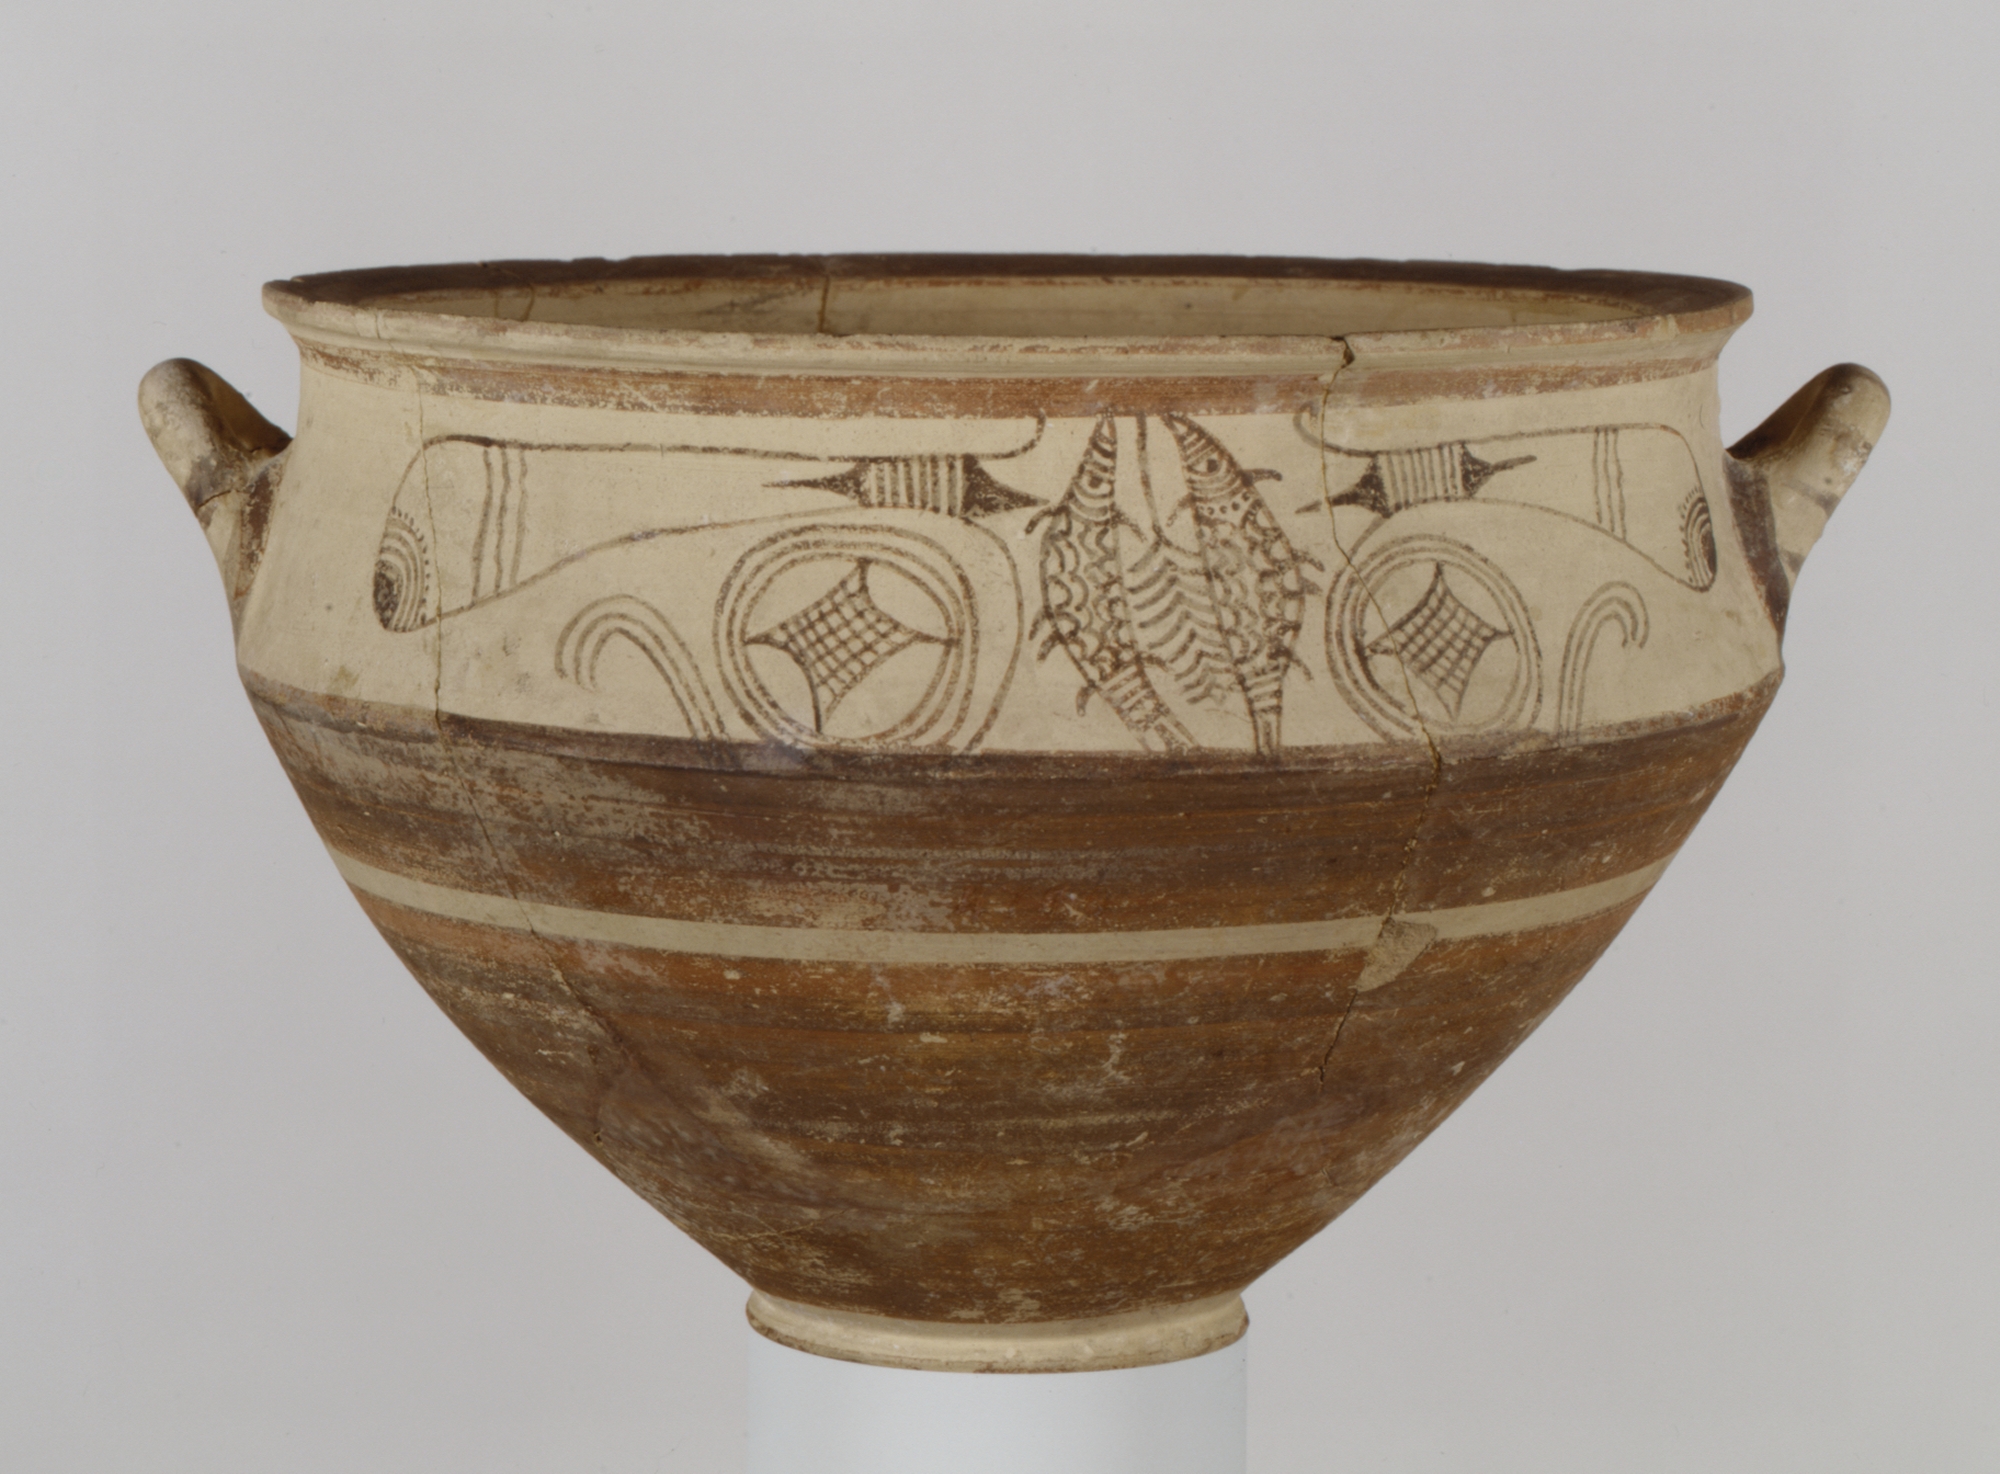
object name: krater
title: Terracotta krater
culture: cypriot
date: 1150-1100 BCE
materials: terracotta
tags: fish